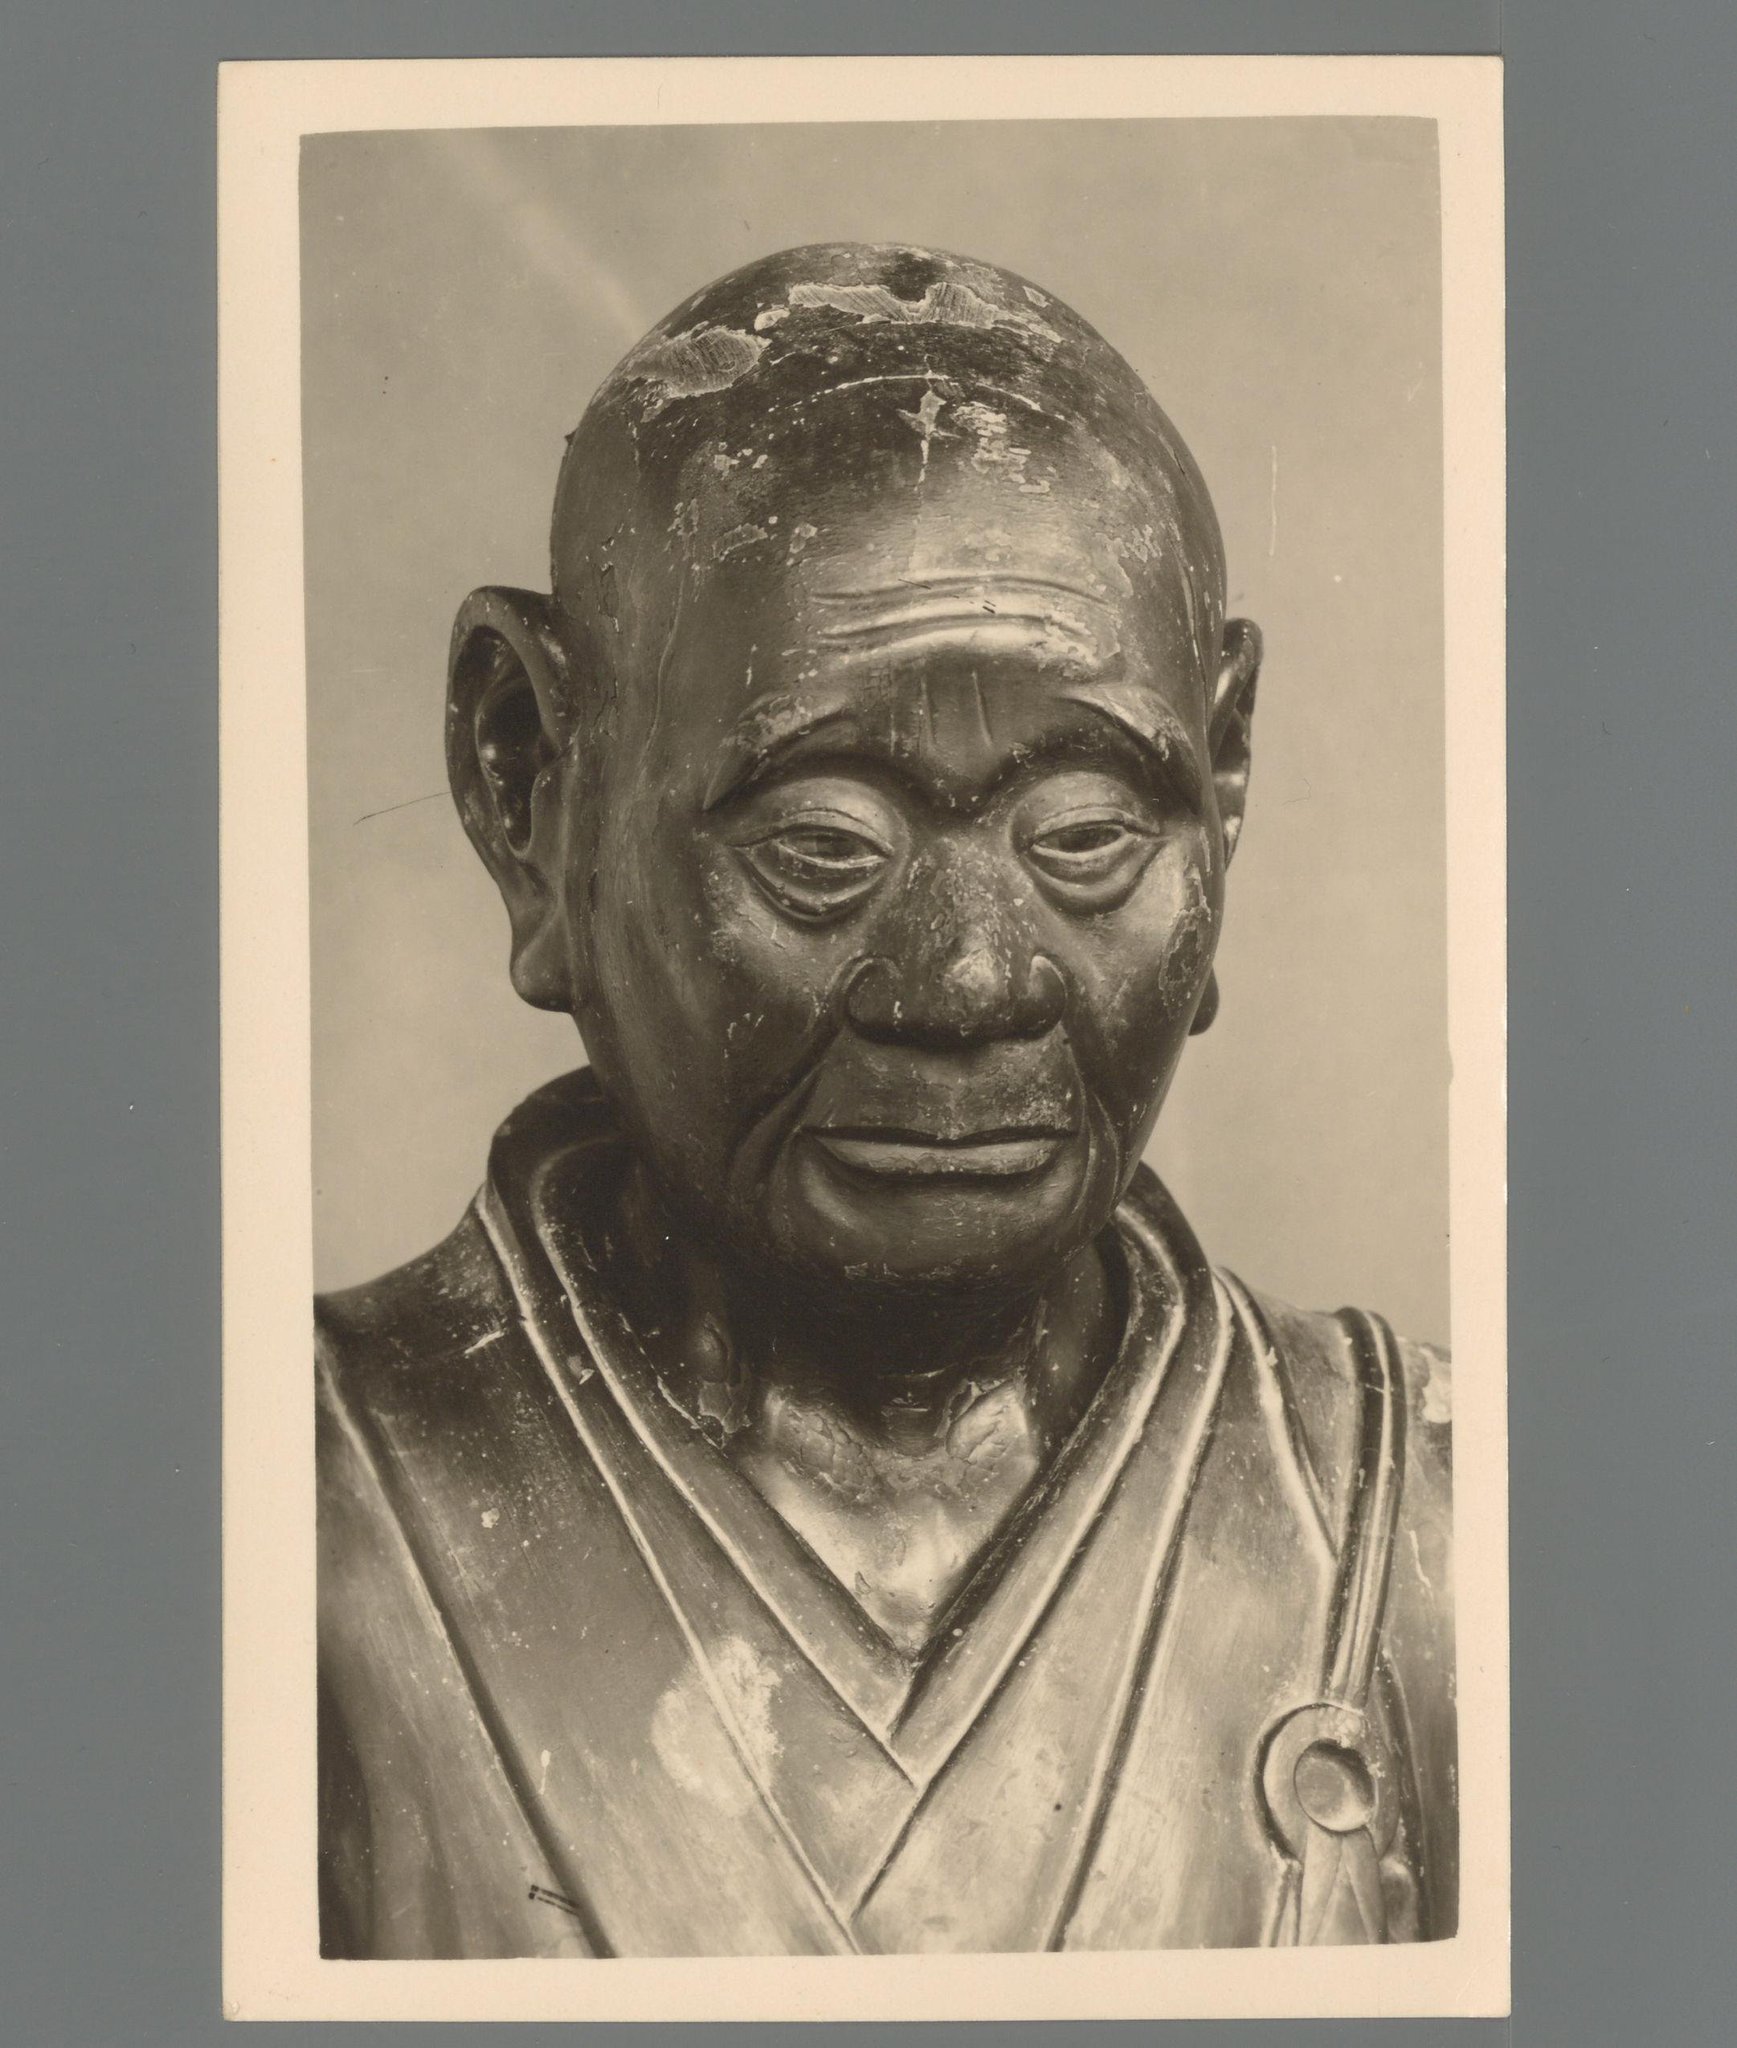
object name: photograph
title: Beeld van een monnik in het Museum für Ostasiatische Kunst te Keulen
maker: Anonymous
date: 1905-1930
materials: photographic support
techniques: photography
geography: cologne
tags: statues, paintings, etc. ~ objects of worship (traditional chinese religions), permanent exhibition, museum